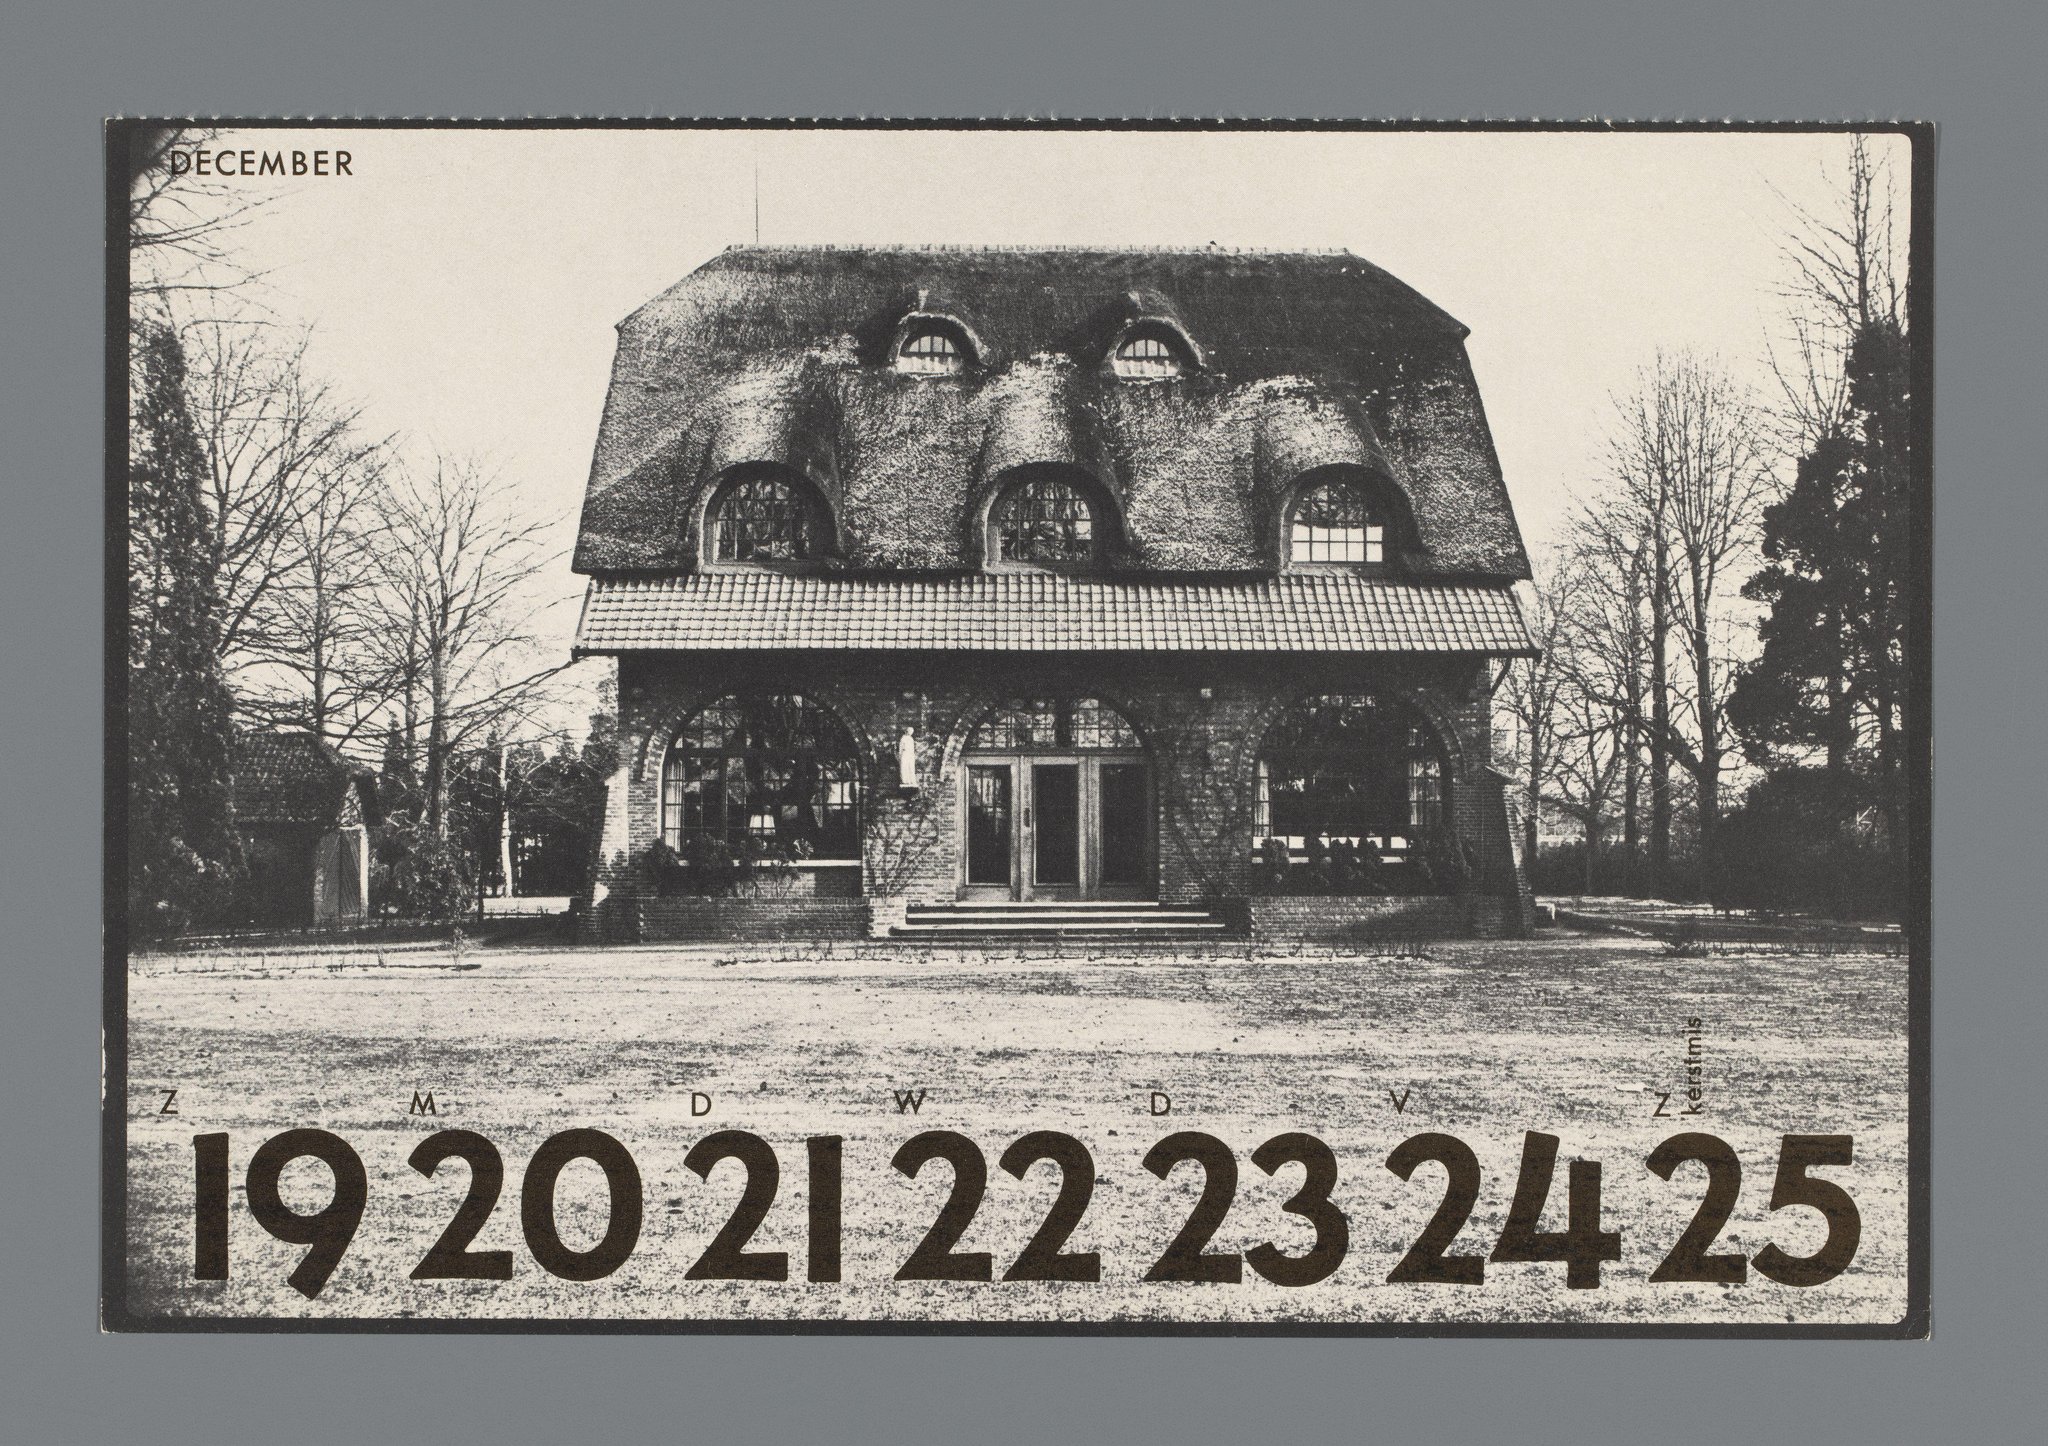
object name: photograph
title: België. Huizen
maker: Anonymous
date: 1900-1950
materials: paper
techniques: offset printed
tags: belgium